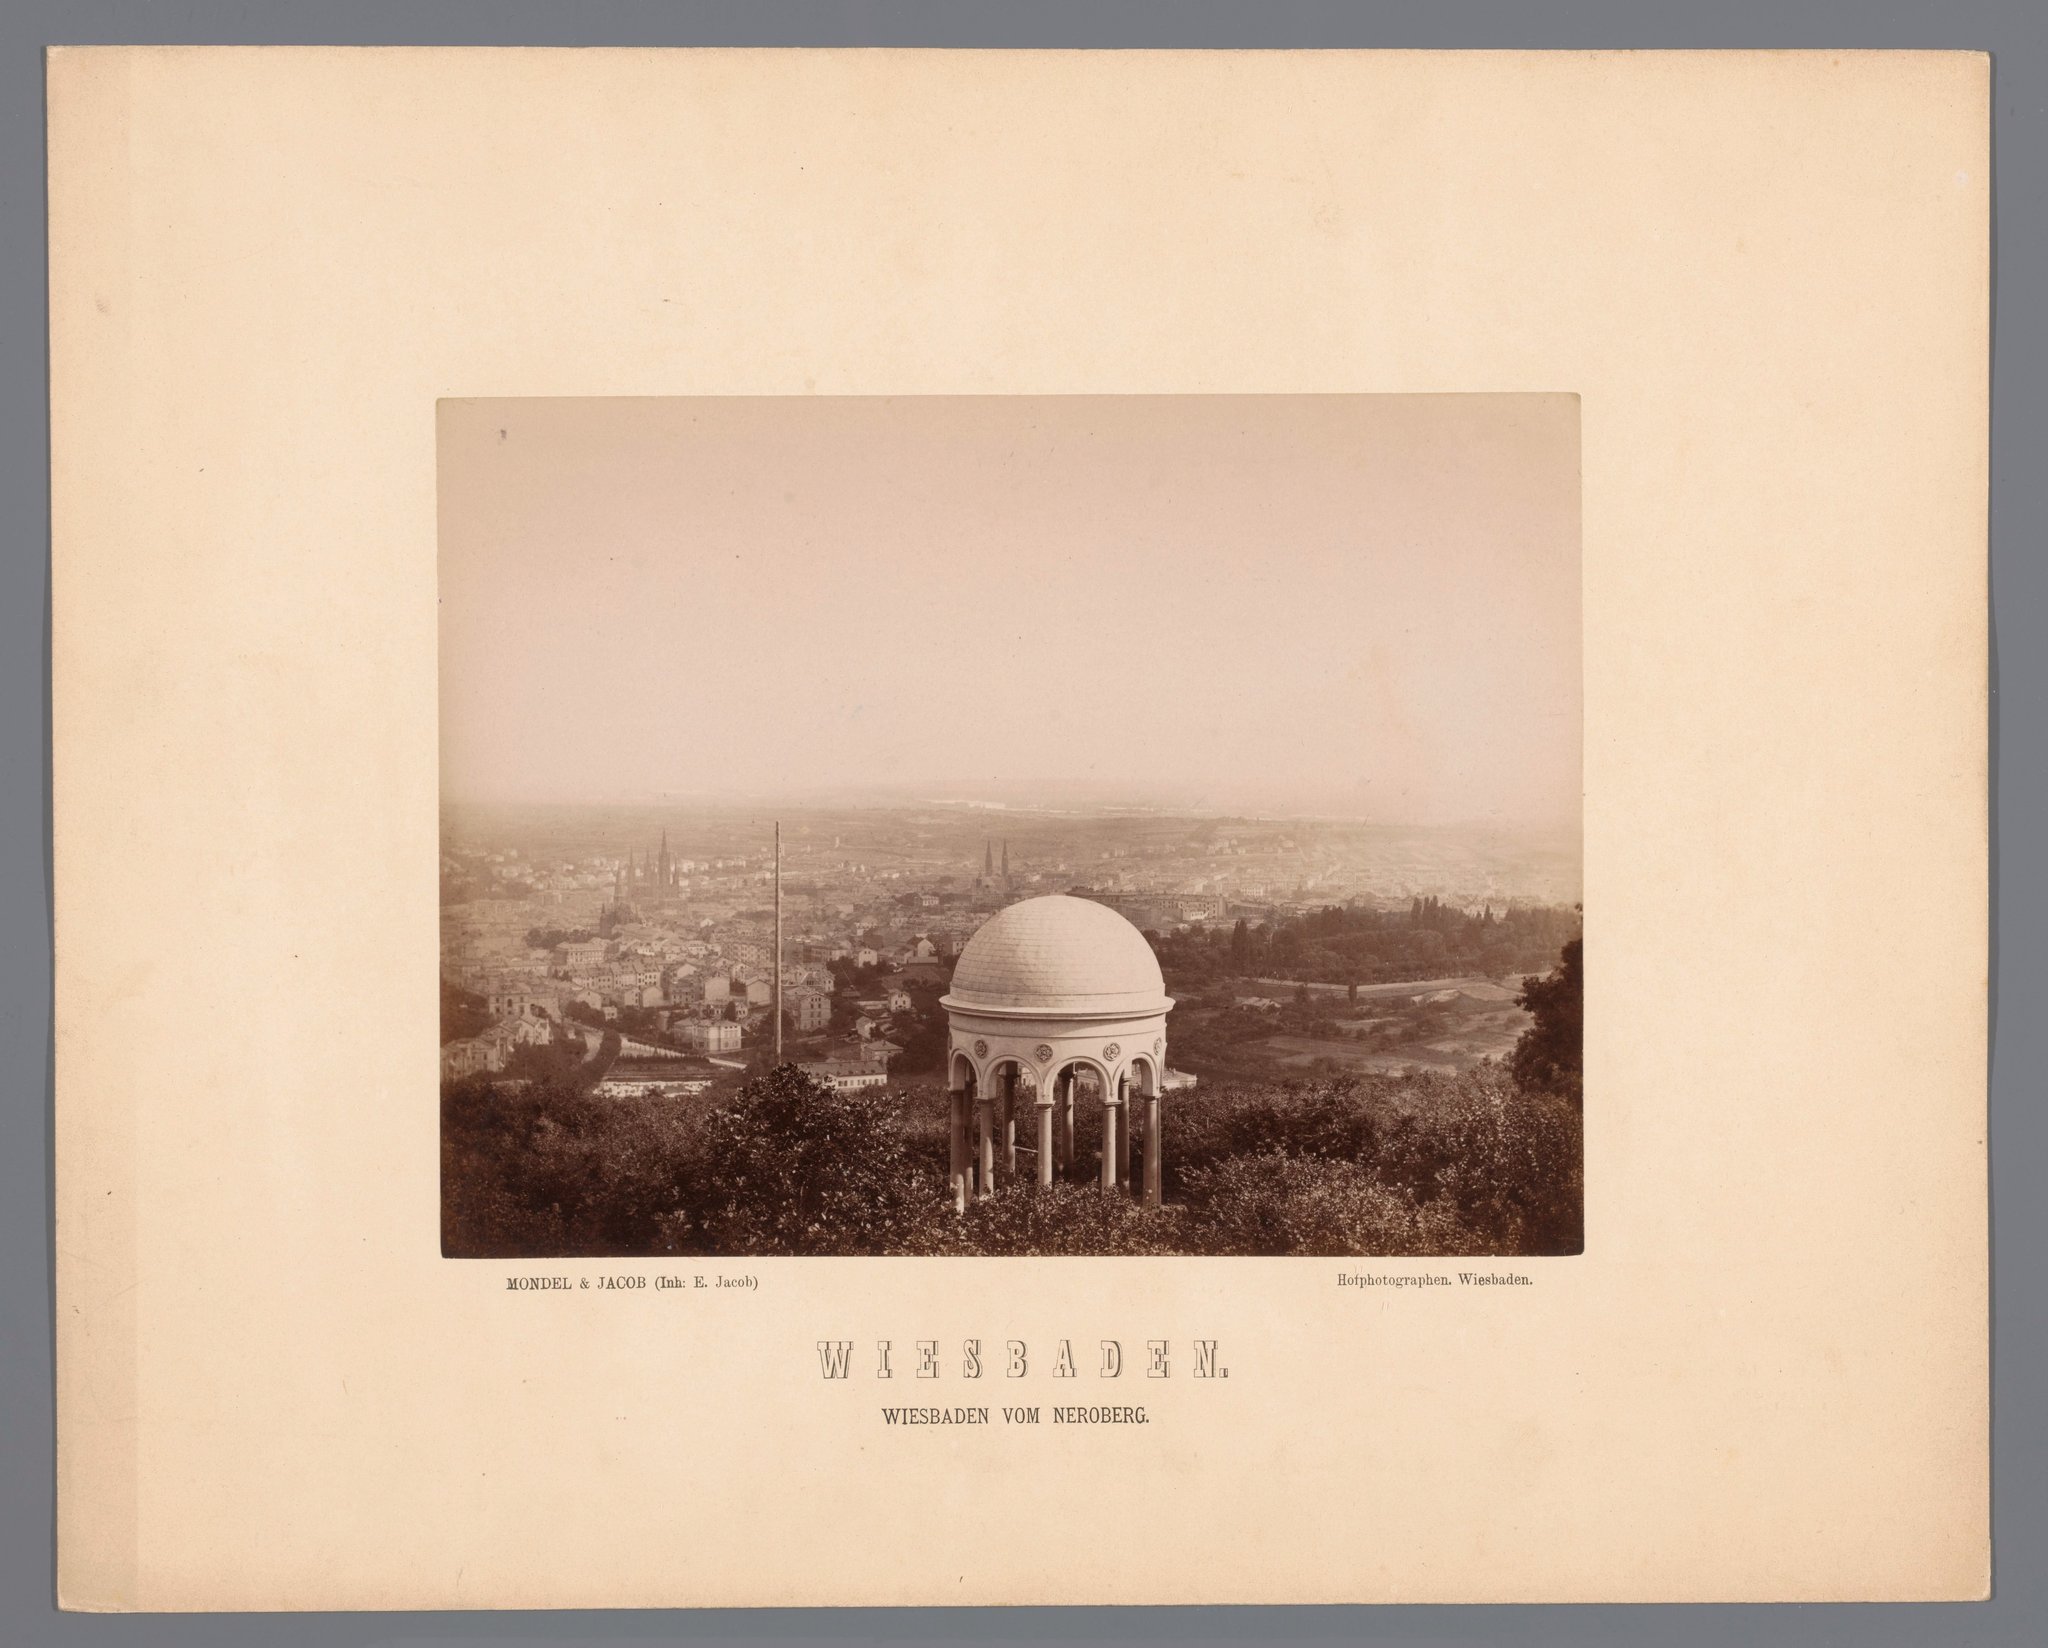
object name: photograph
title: Wiesbaden vom Neroberg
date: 1870-1890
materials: cardboard, paper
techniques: albumen print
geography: wiesbaden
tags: city-view in general; 'veduta', landscape with monument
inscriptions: title: ‘Wiesbaden./ Wiesbaden vom Neroberg.’, inscription: ‘Mondel & Jacob (inh: E. Jacob) Hofphotographen. Wiesbaden.’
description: Gezicht op Wiesbaden, gezien van vlak achter de Monopteros op de Neroberg.